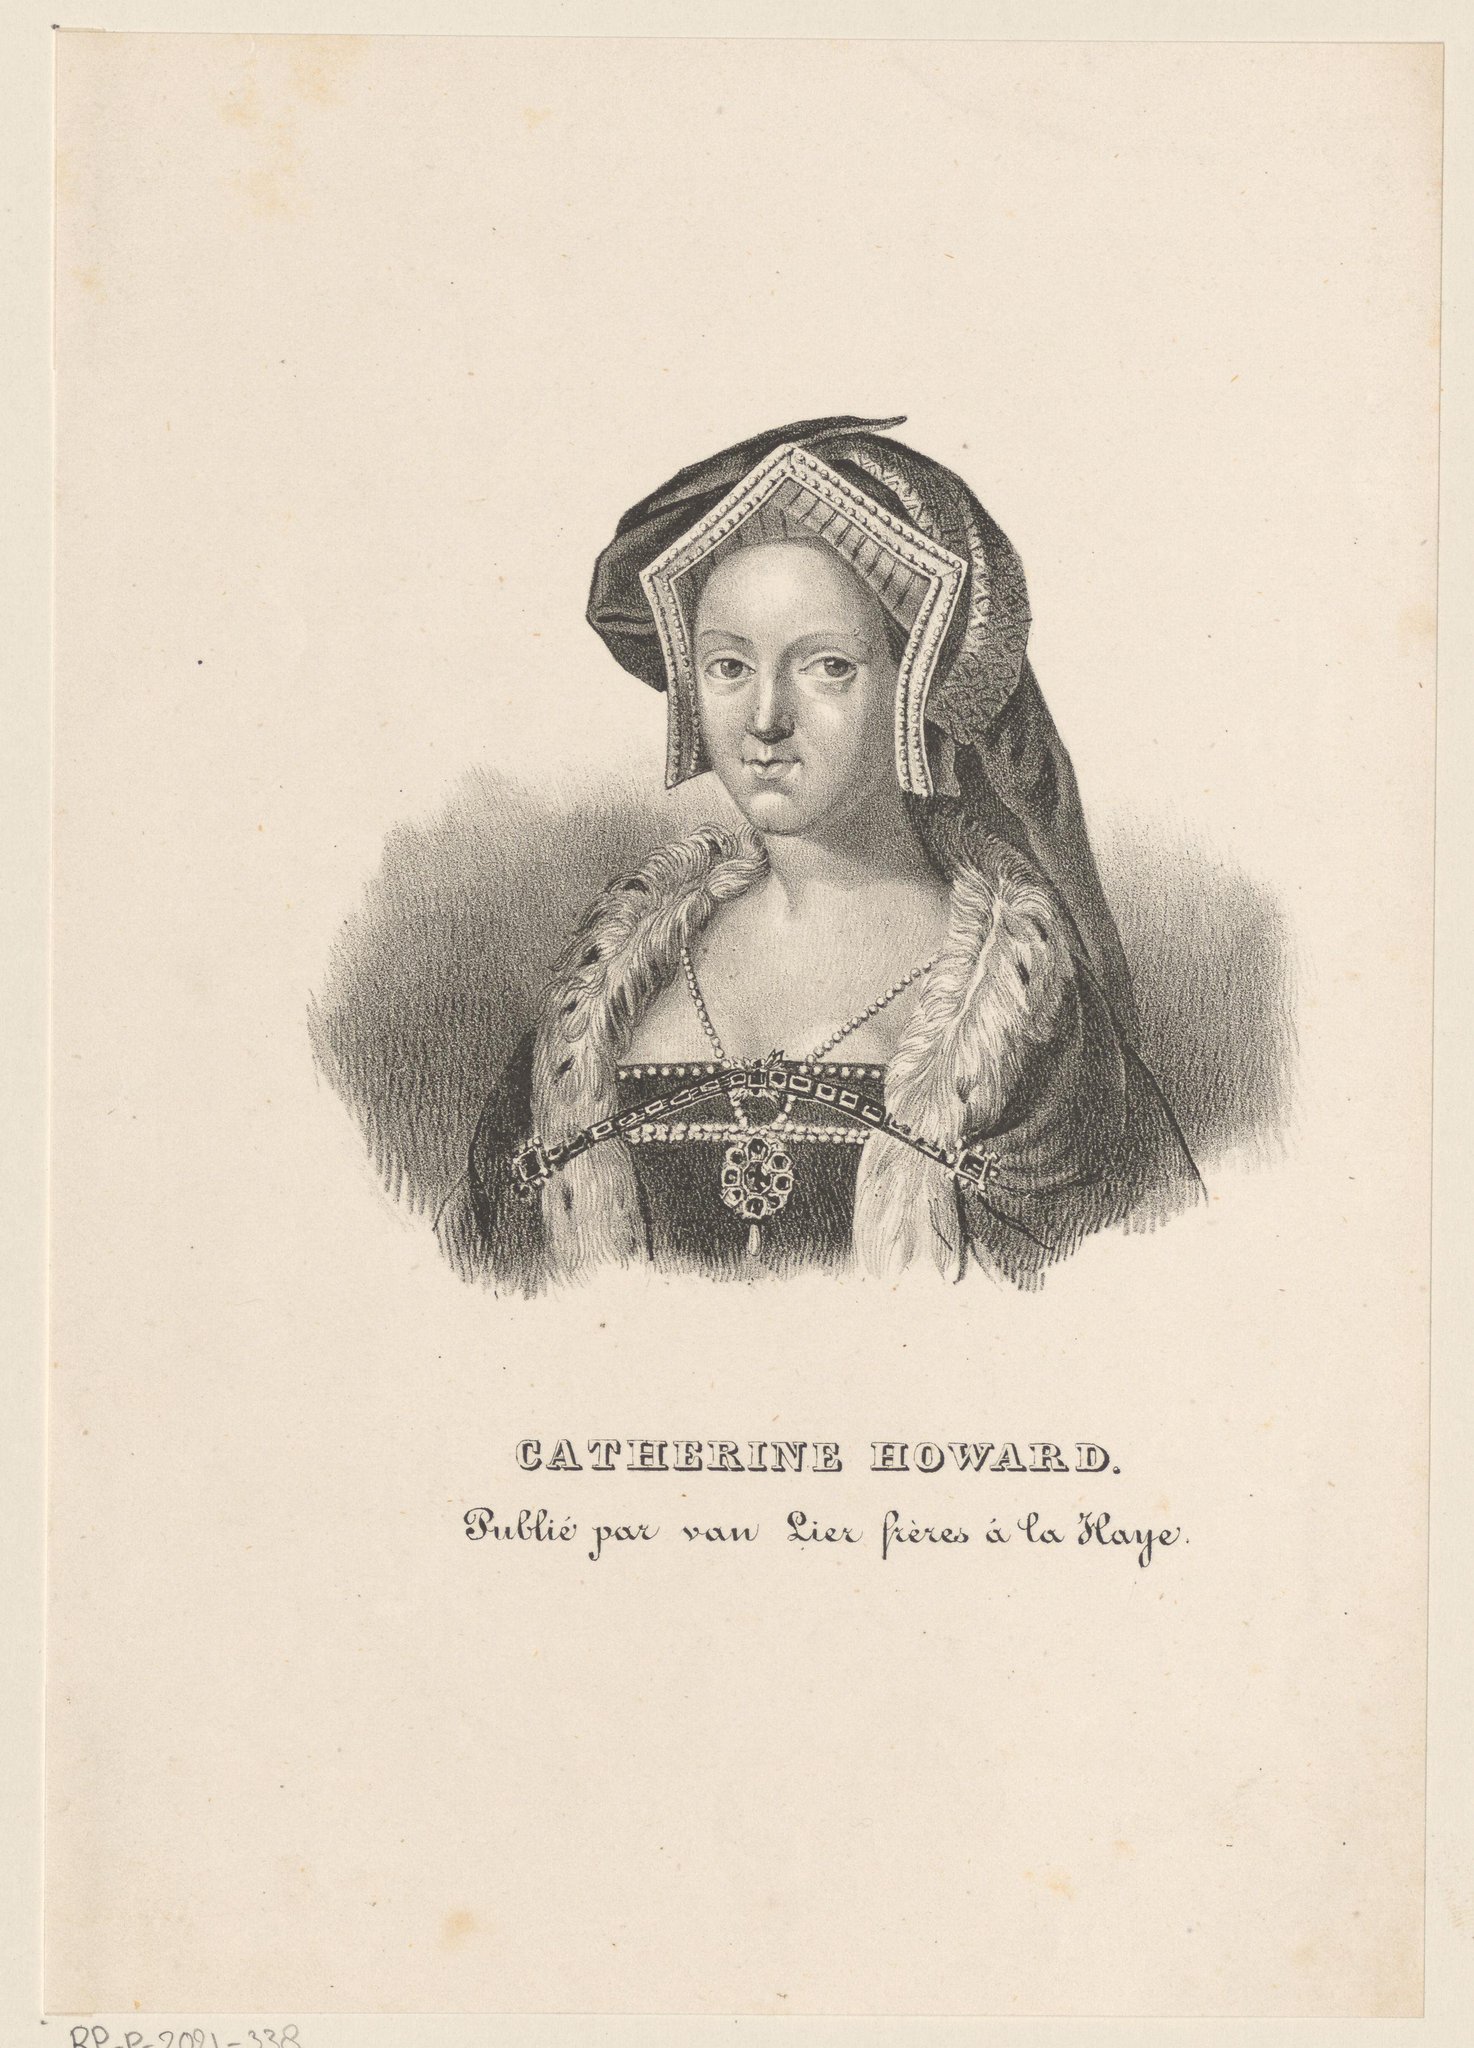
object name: print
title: Portret van Catharina Howard, koningin van Engeland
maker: Anonymous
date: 1833-1846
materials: paper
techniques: lithograph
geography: the hague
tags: historical persons - bb - woman, queen